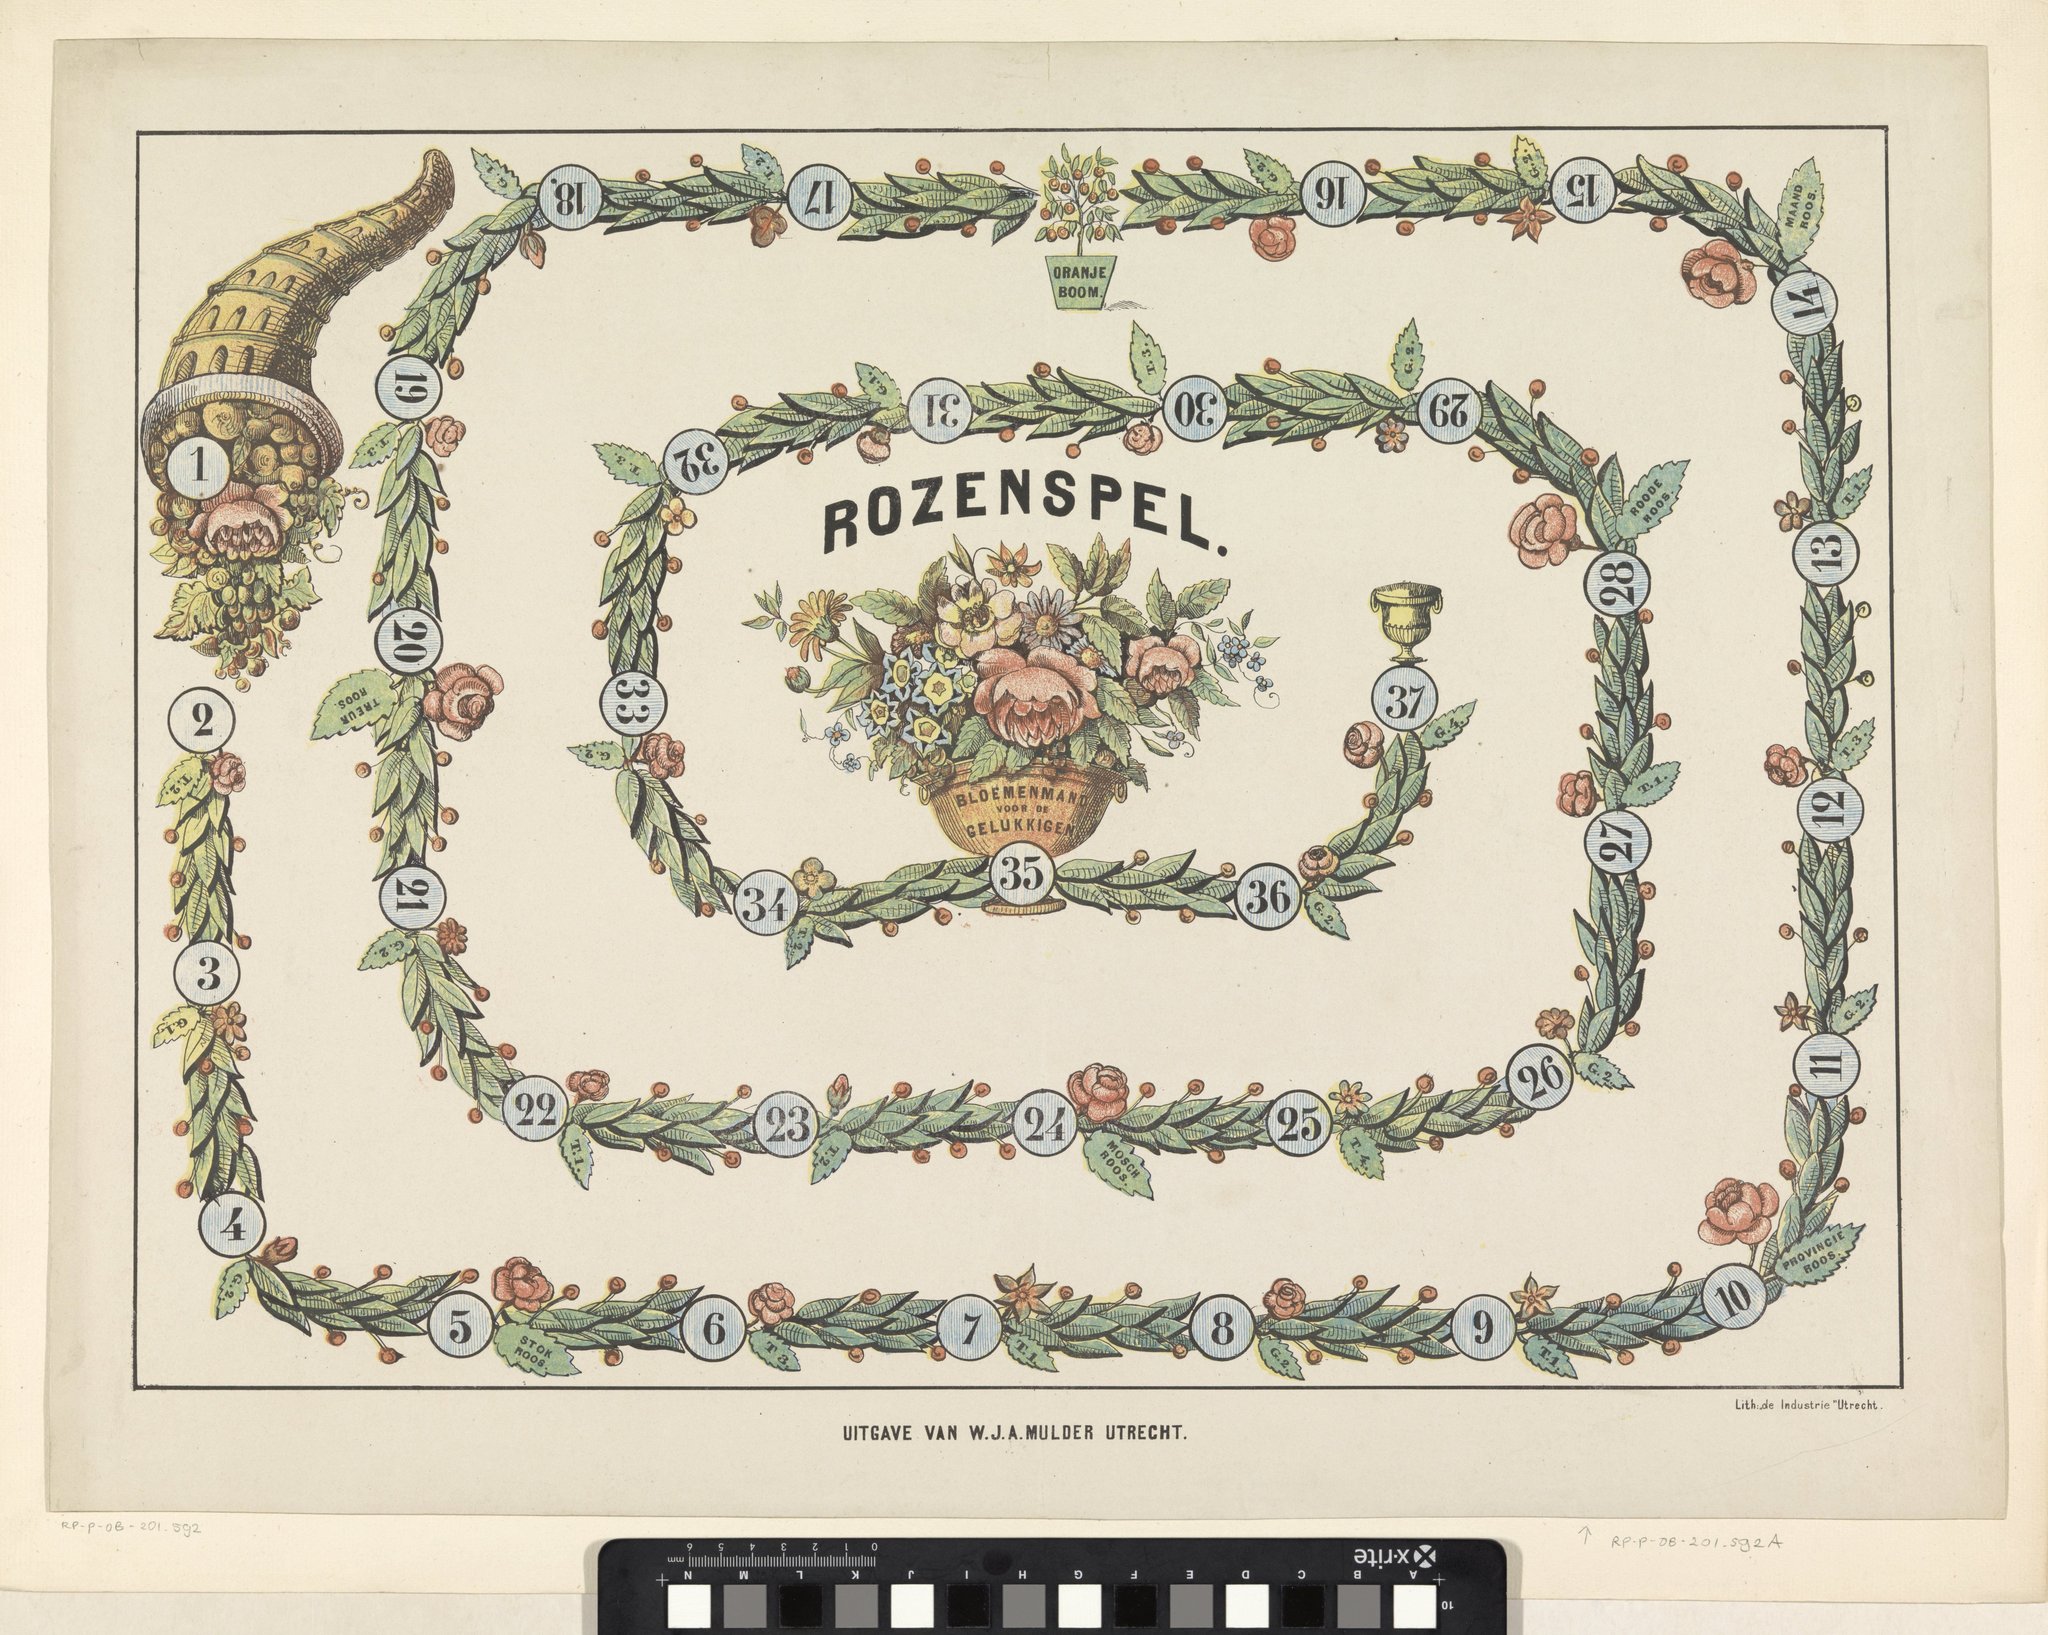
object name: gameboard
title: Rozenspel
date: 1857-1866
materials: paper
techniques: colour, lithograph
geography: rotterdam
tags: board-games of chance, flowers: rose, flowers in a vase, board-games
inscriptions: collector's mark: Lugt 2760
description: Bordspel met 37 nummers in rondjes, met elkaar verbonden met takken met rozen. In het midden een grote vaas met verschillende bloemen.